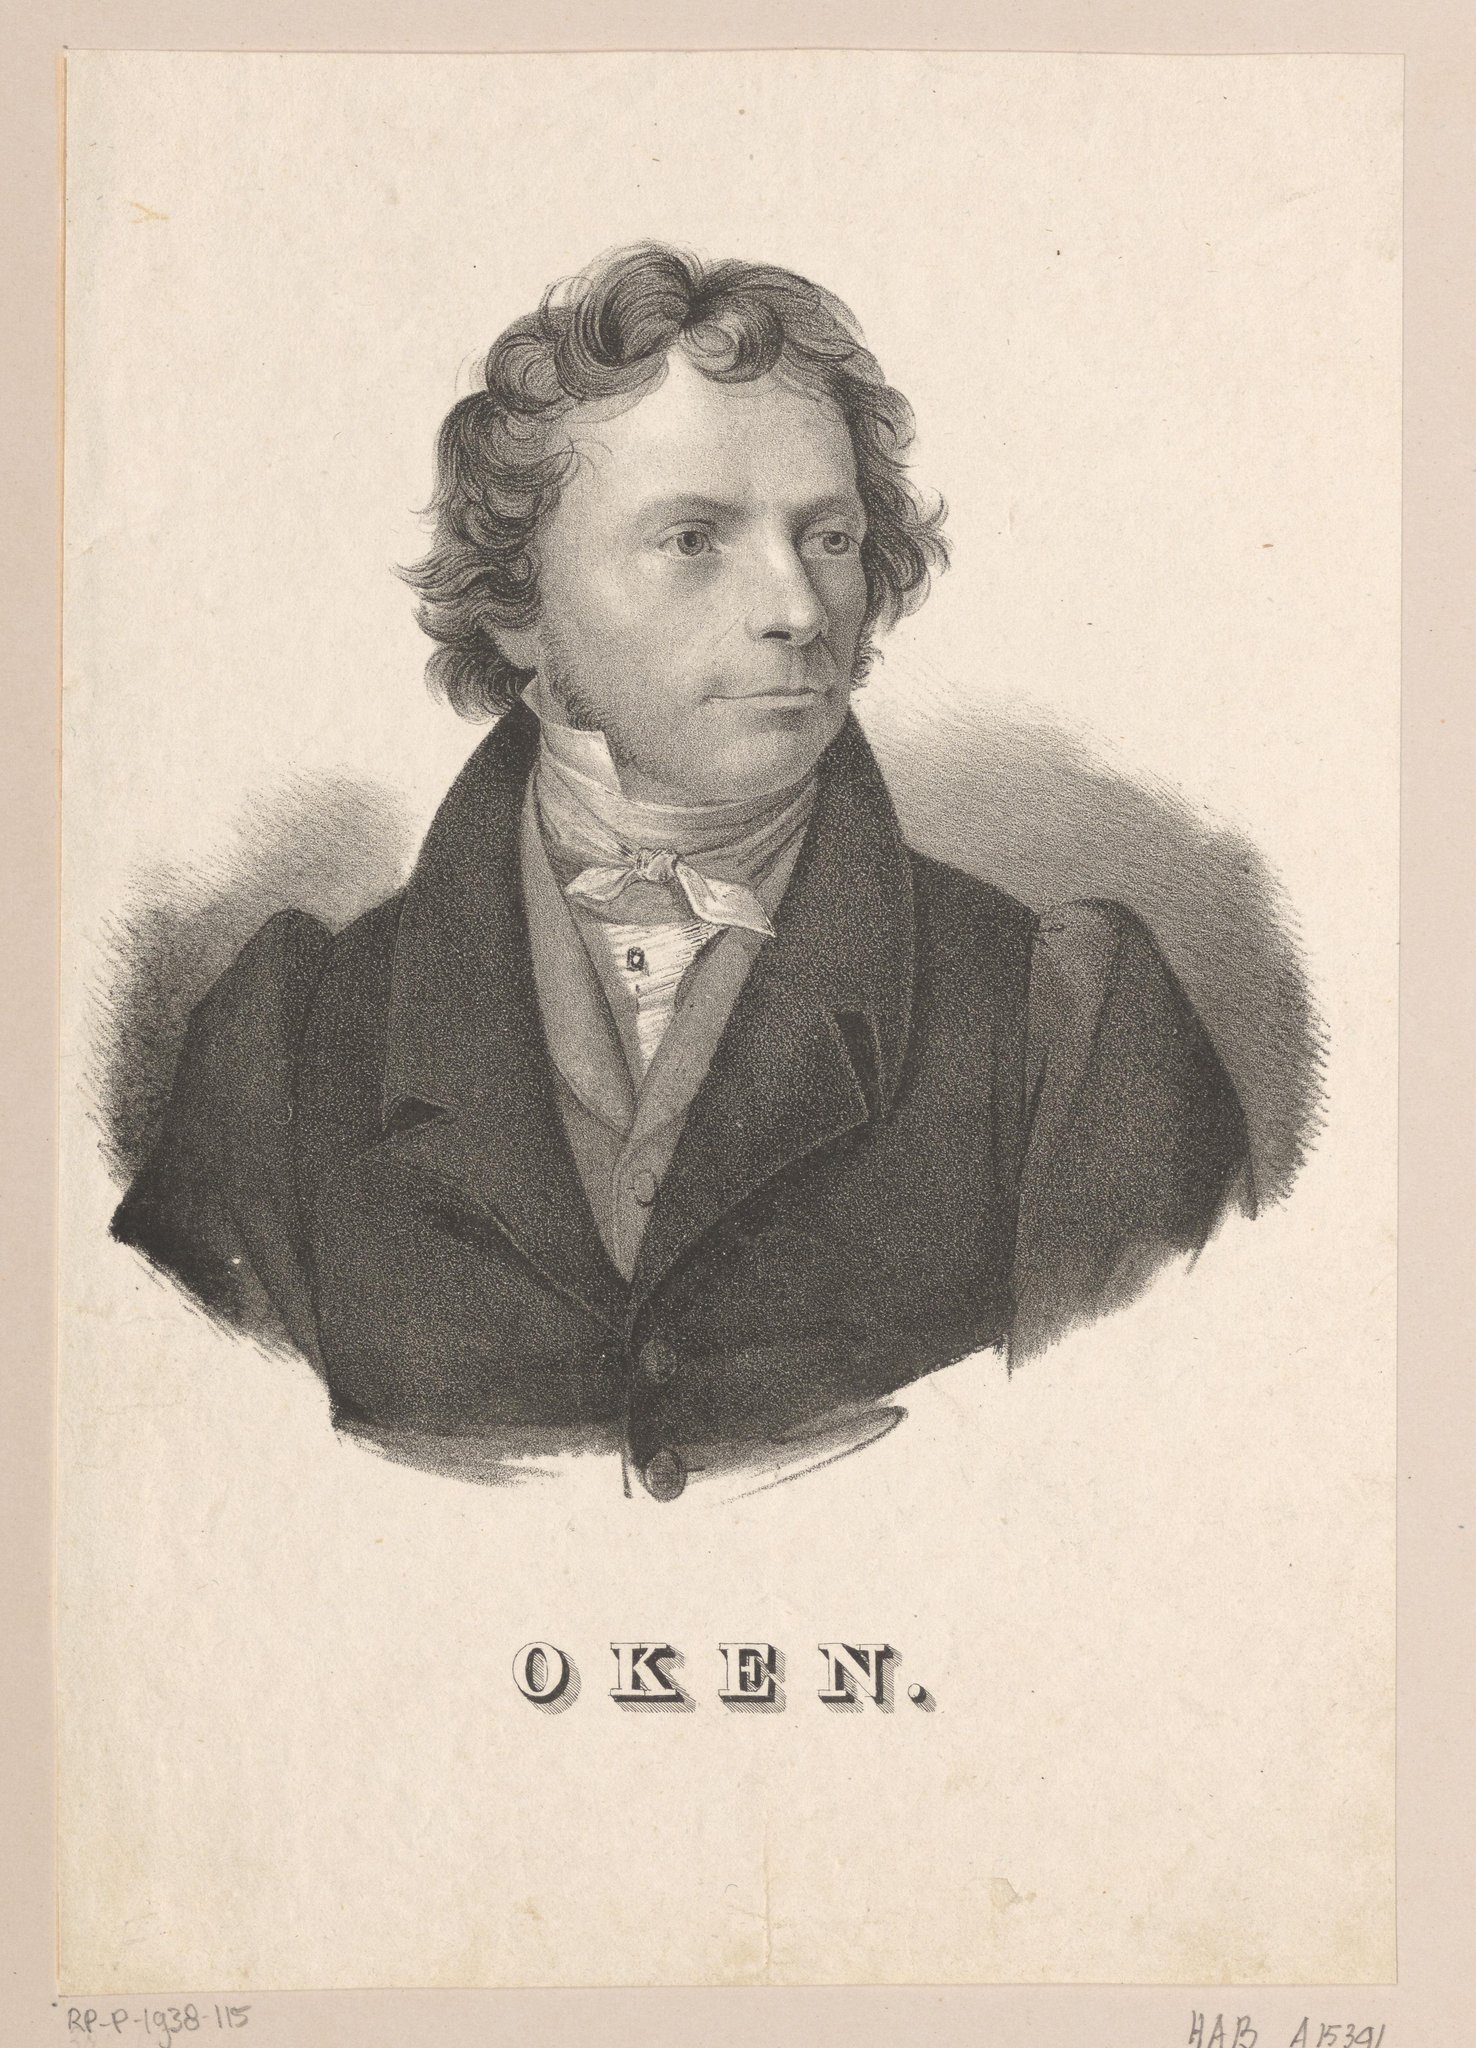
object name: print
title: Portret van Lorenz Oken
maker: Anonymous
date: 1799-1899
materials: paper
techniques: lithograph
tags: historical persons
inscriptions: collector's mark: Lugt 2228